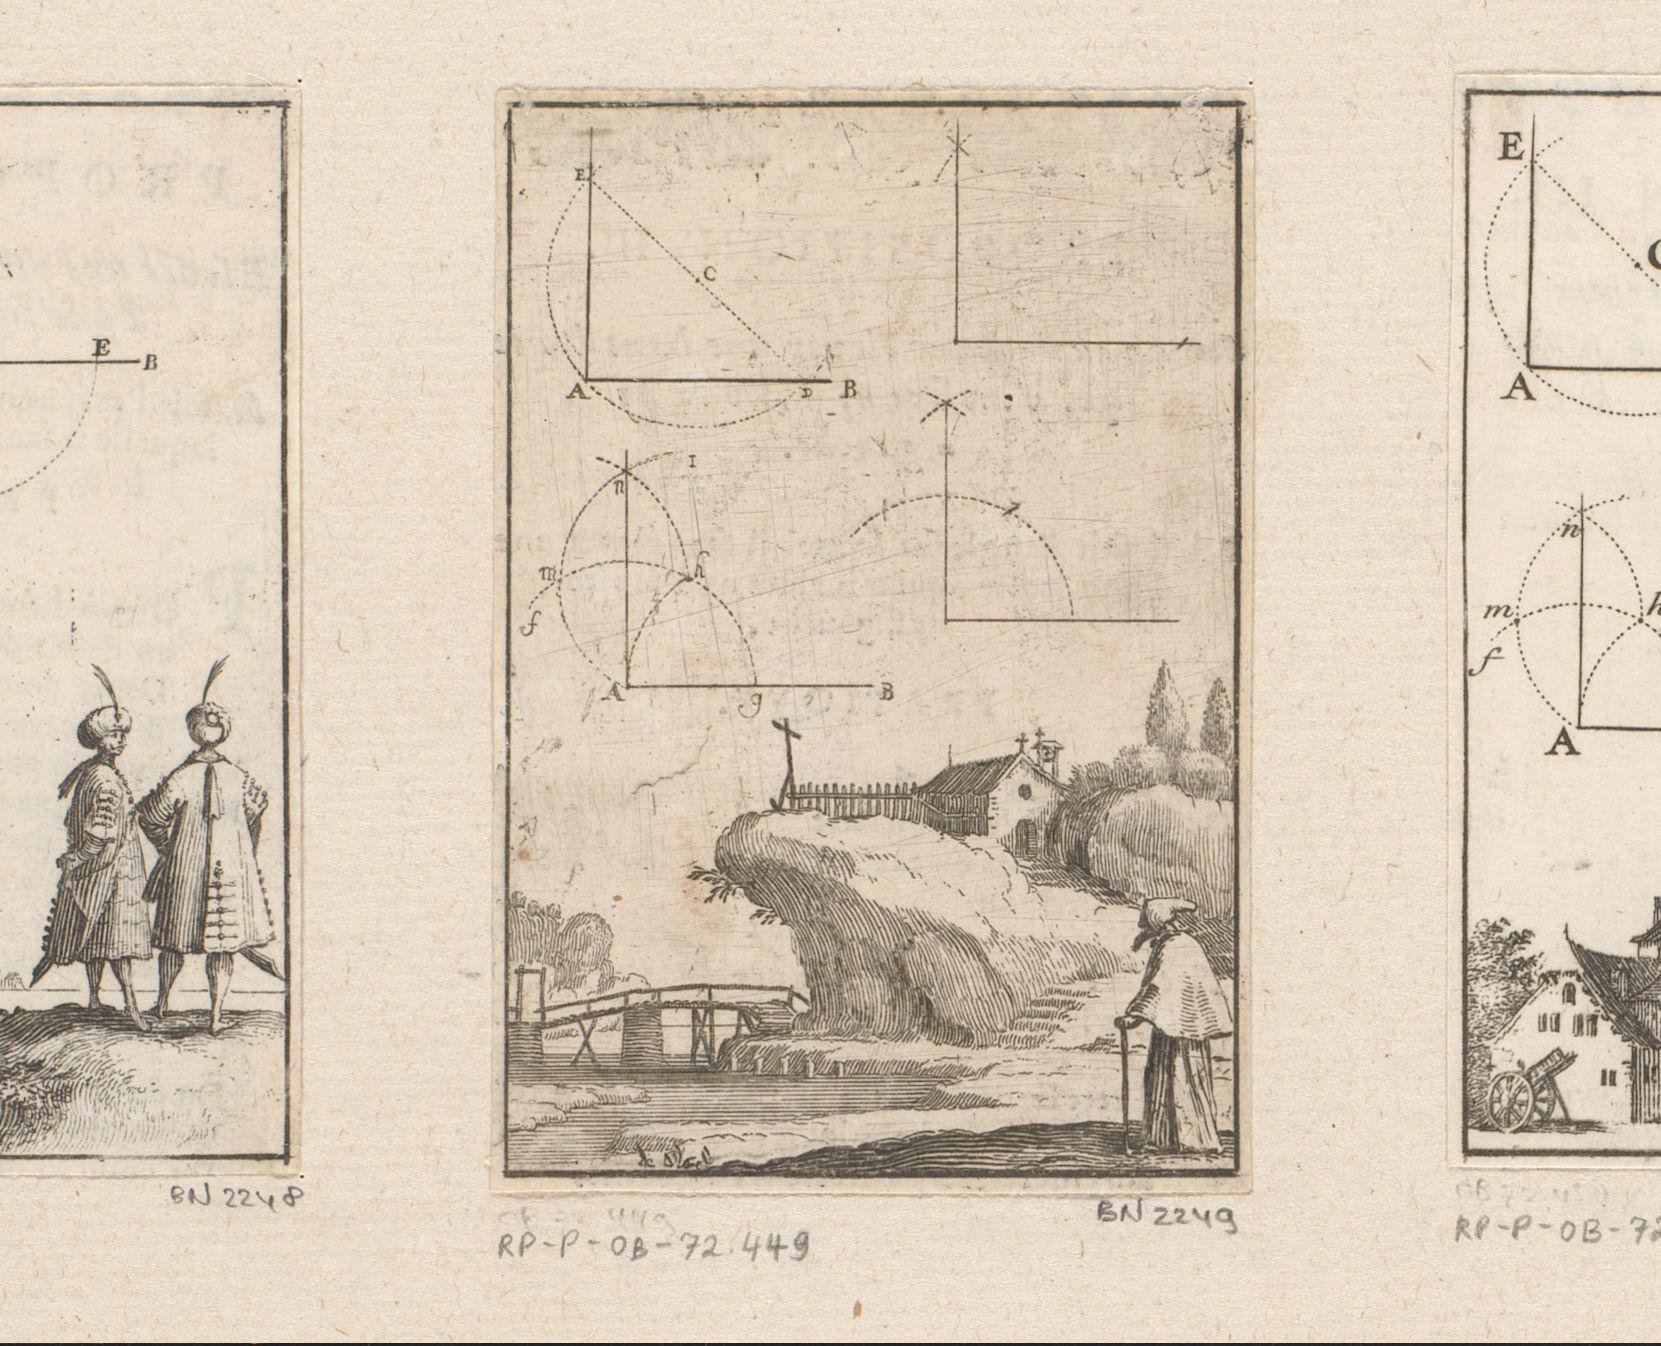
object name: book illustration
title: Opbouw van een loodrechte lijn met onderaan een gezicht op een huis op een heuvel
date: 1669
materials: paper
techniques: etching, letterpress printing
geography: france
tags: low hill country, adult man, rural housing, e.g. country-house, villa, cottage, planimetry, geometry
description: Prent uit: Pratique de la géometrie, sur le papier et sur le terrain. Avec un nouvel ordre et une méthode particulière. Parijs: Thomas Jolly, 1669.